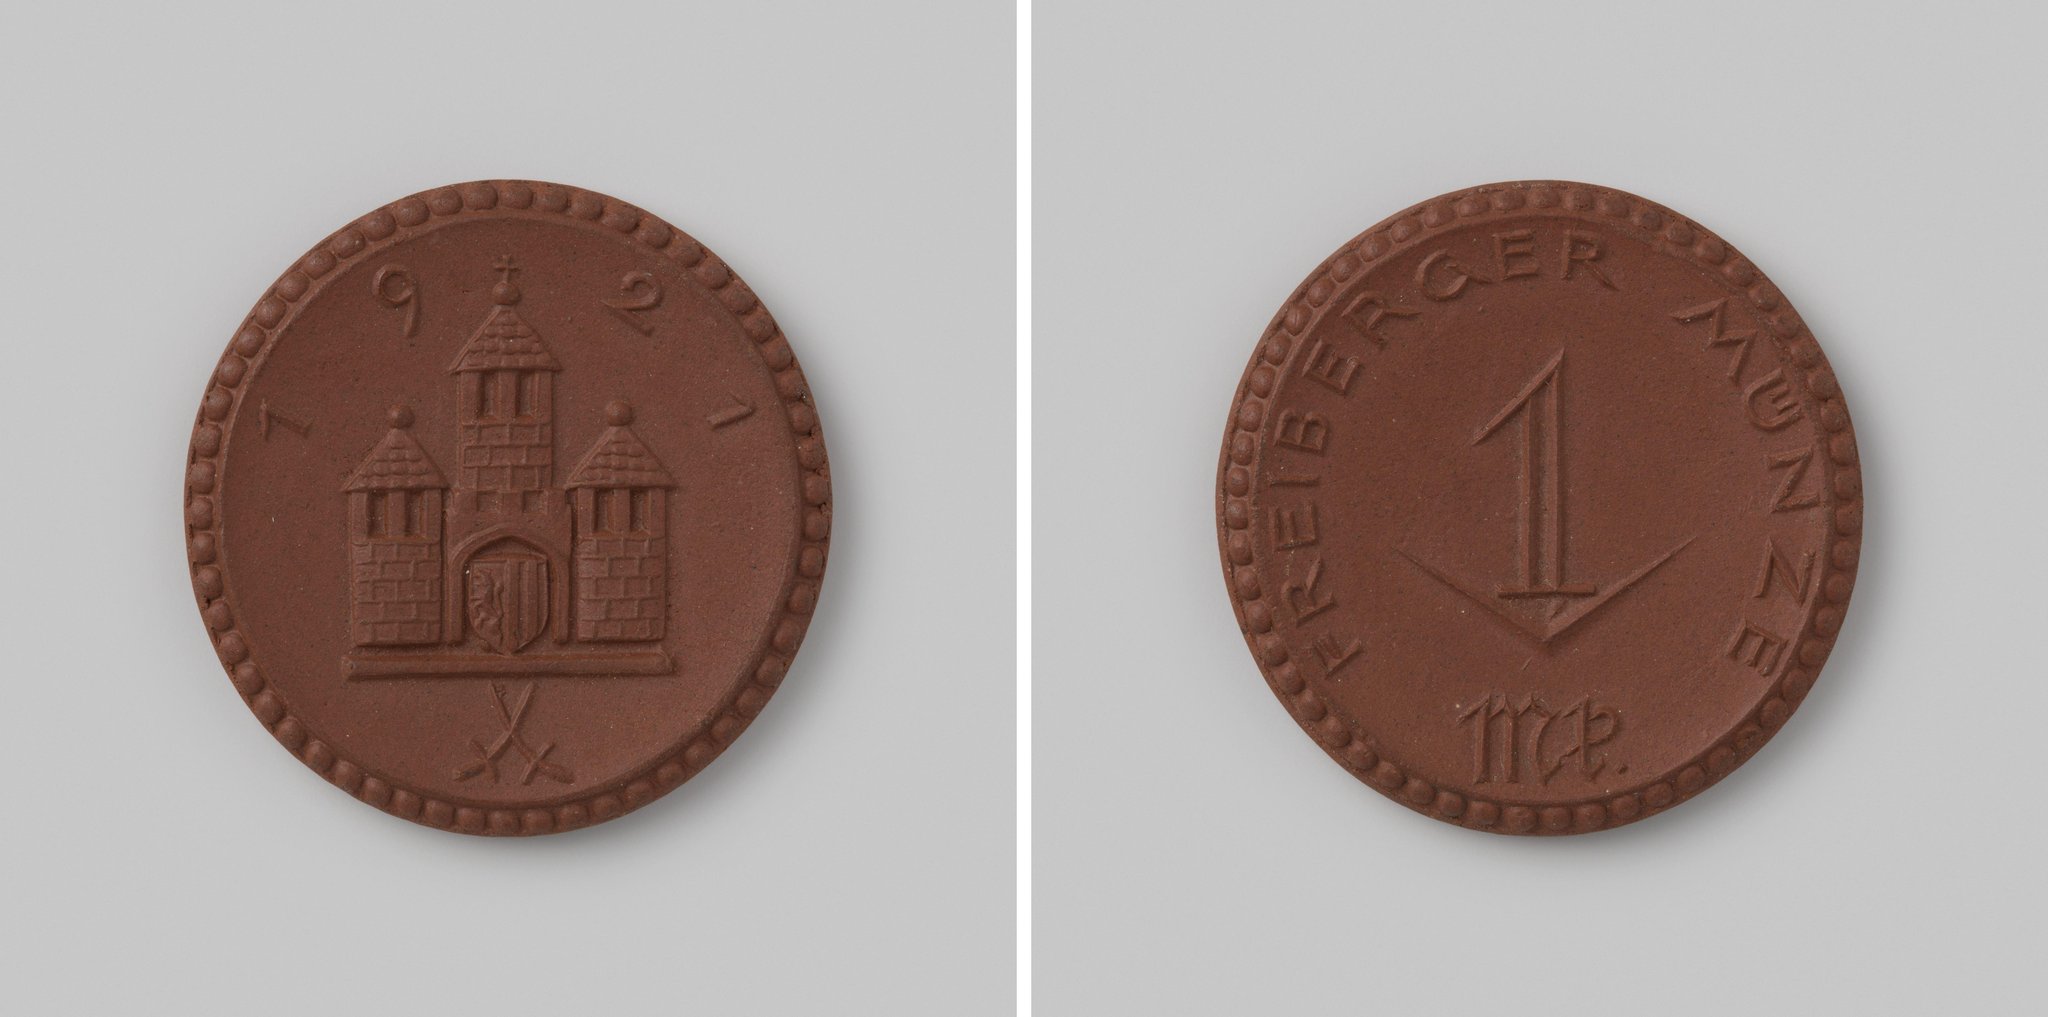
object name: coin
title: Mark uit Duitsland, Freiberg, 1921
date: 1921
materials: porcelain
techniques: casting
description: Porseleinen pseudomunt. Voorzijde: kerkgebouw, waarboven jaartal. Keerzijde: waarde-aanduiding in twee regels. Daarboven plaatsaanduiding. Gladde rand.